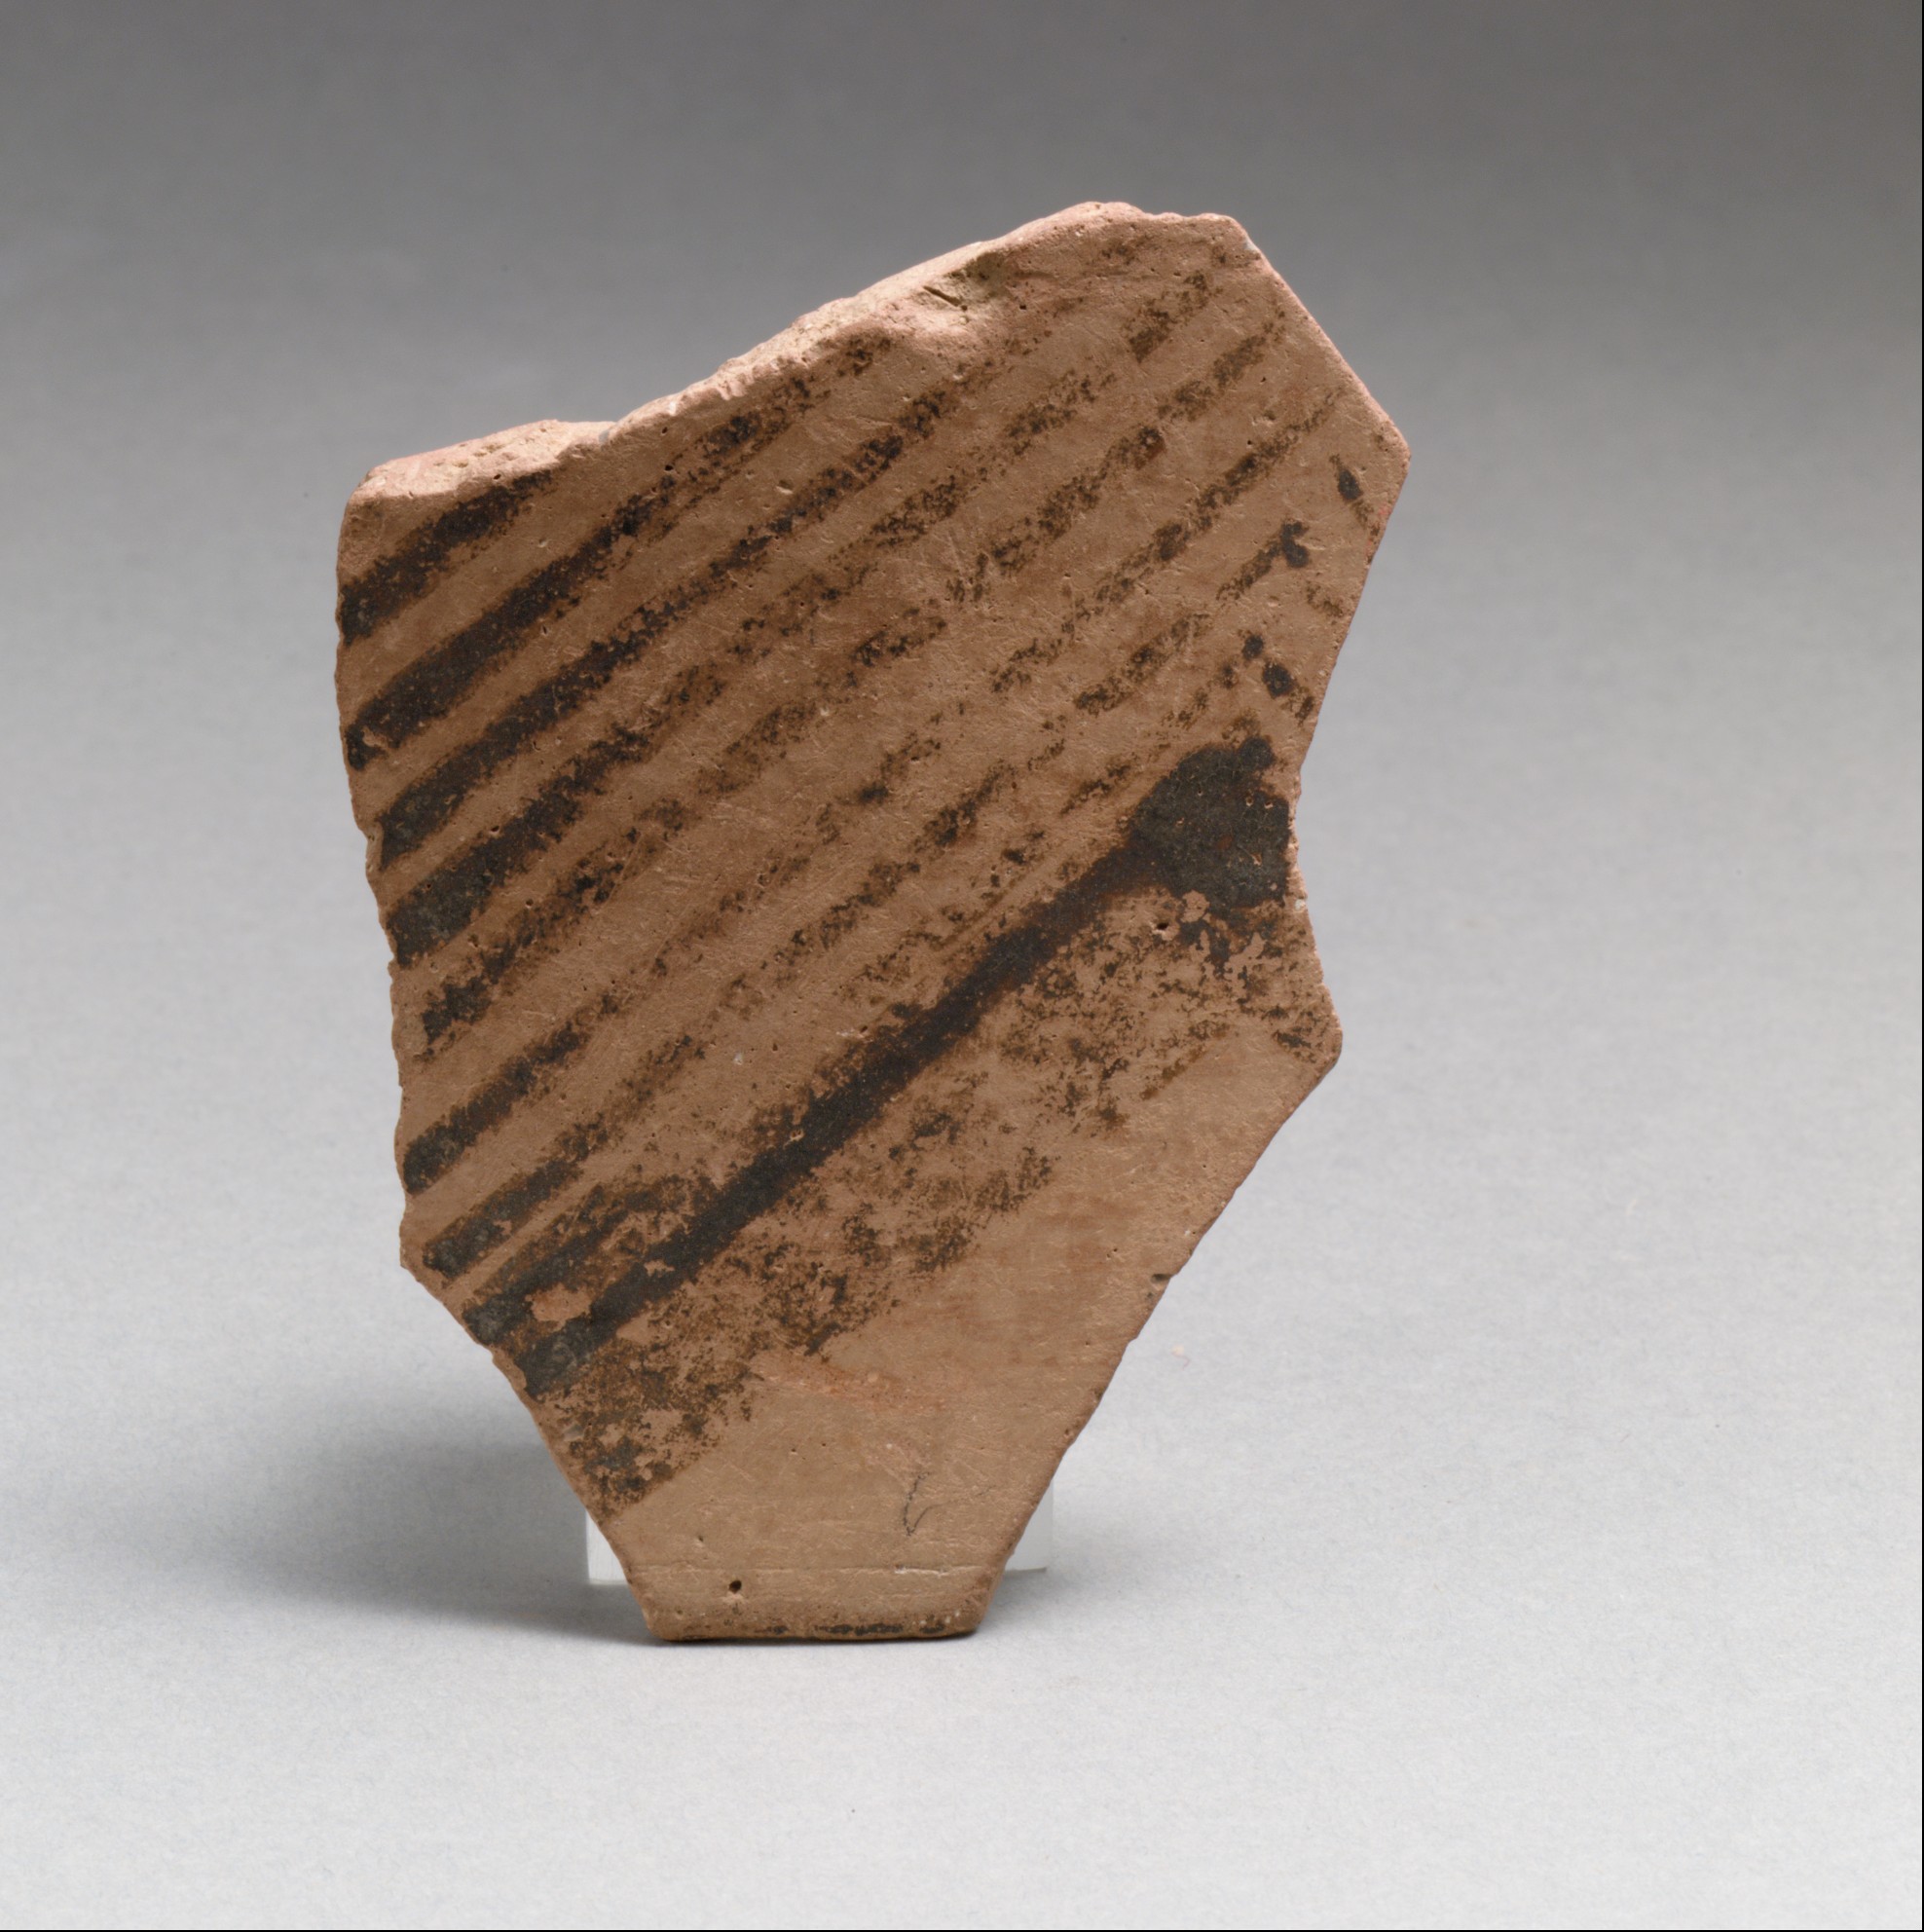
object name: vase fragment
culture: neolithic, hagiorgetika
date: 4000-3000 BCE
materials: terracotta